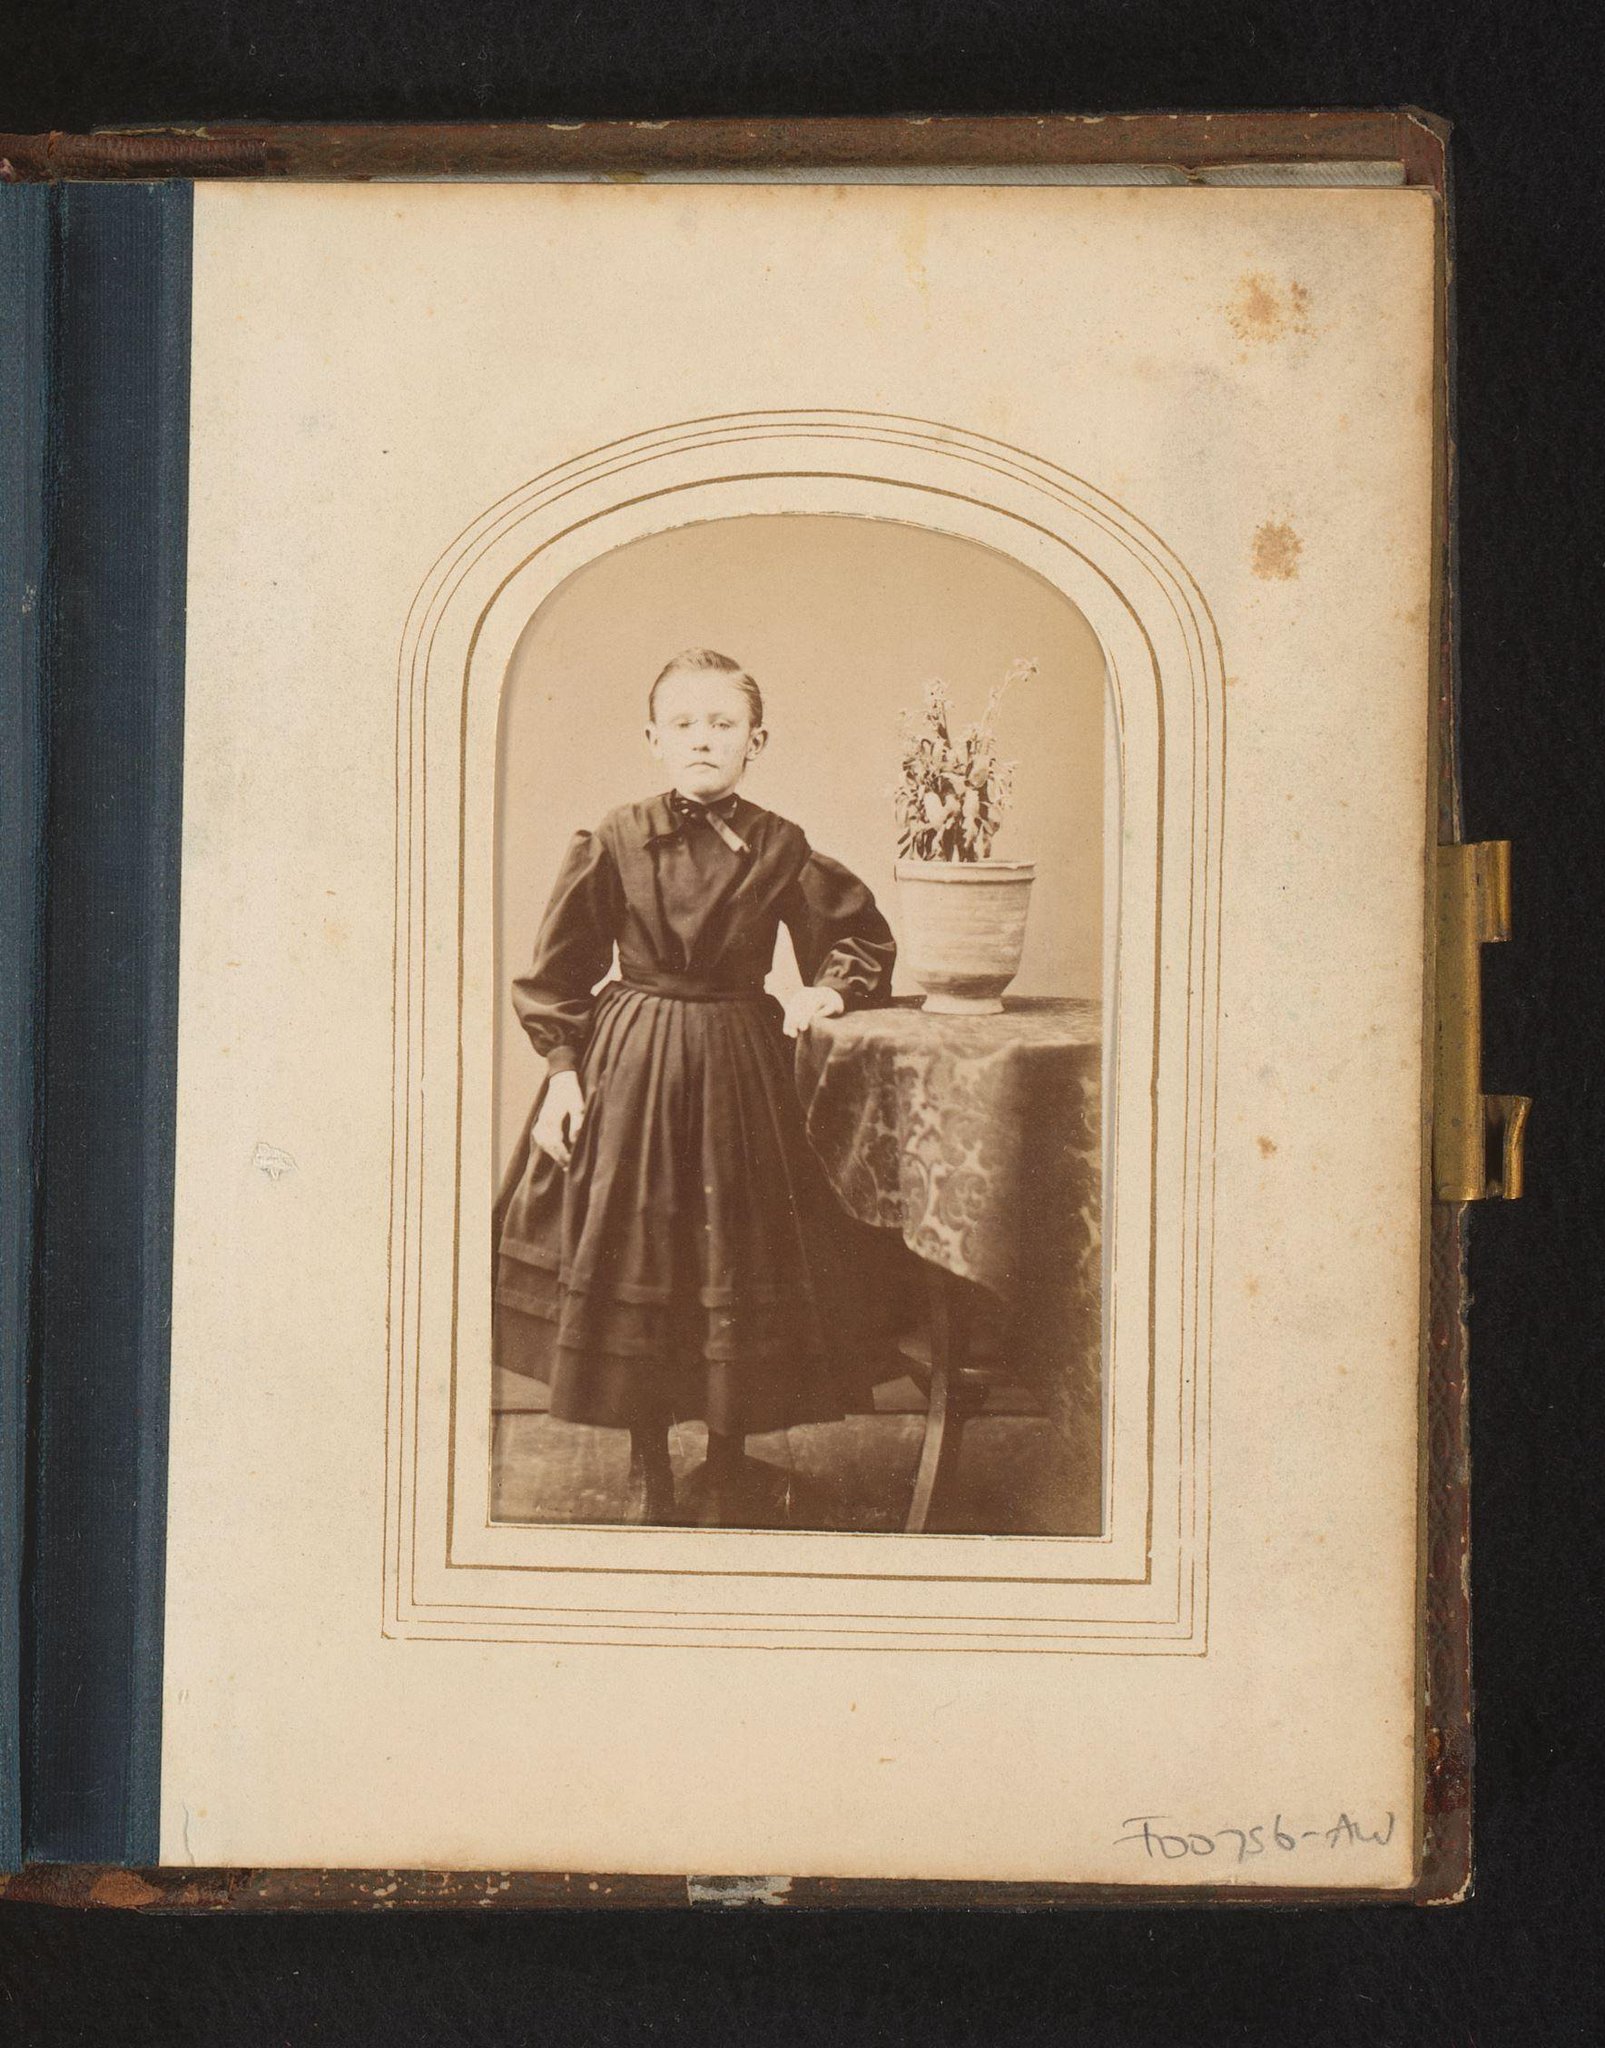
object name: album leaf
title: Portret van een meisje, staand bij een tafel met plant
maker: petrus wagenaar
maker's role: fotograaf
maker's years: 1819-1896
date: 1860-1896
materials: cardboard, photographic support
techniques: albumen print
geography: veendam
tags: plants (in general), historical persons - bb - woman, girl (child between toddler and youth), table, standing figure - aa - female human figure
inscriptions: inscription: ‘Photographisch/ Atelier/ van/ P. Wagenaar./ Oosterdiep/ Veendam/ De plaat blijft 4 weken tot nabestelling bewaard.’